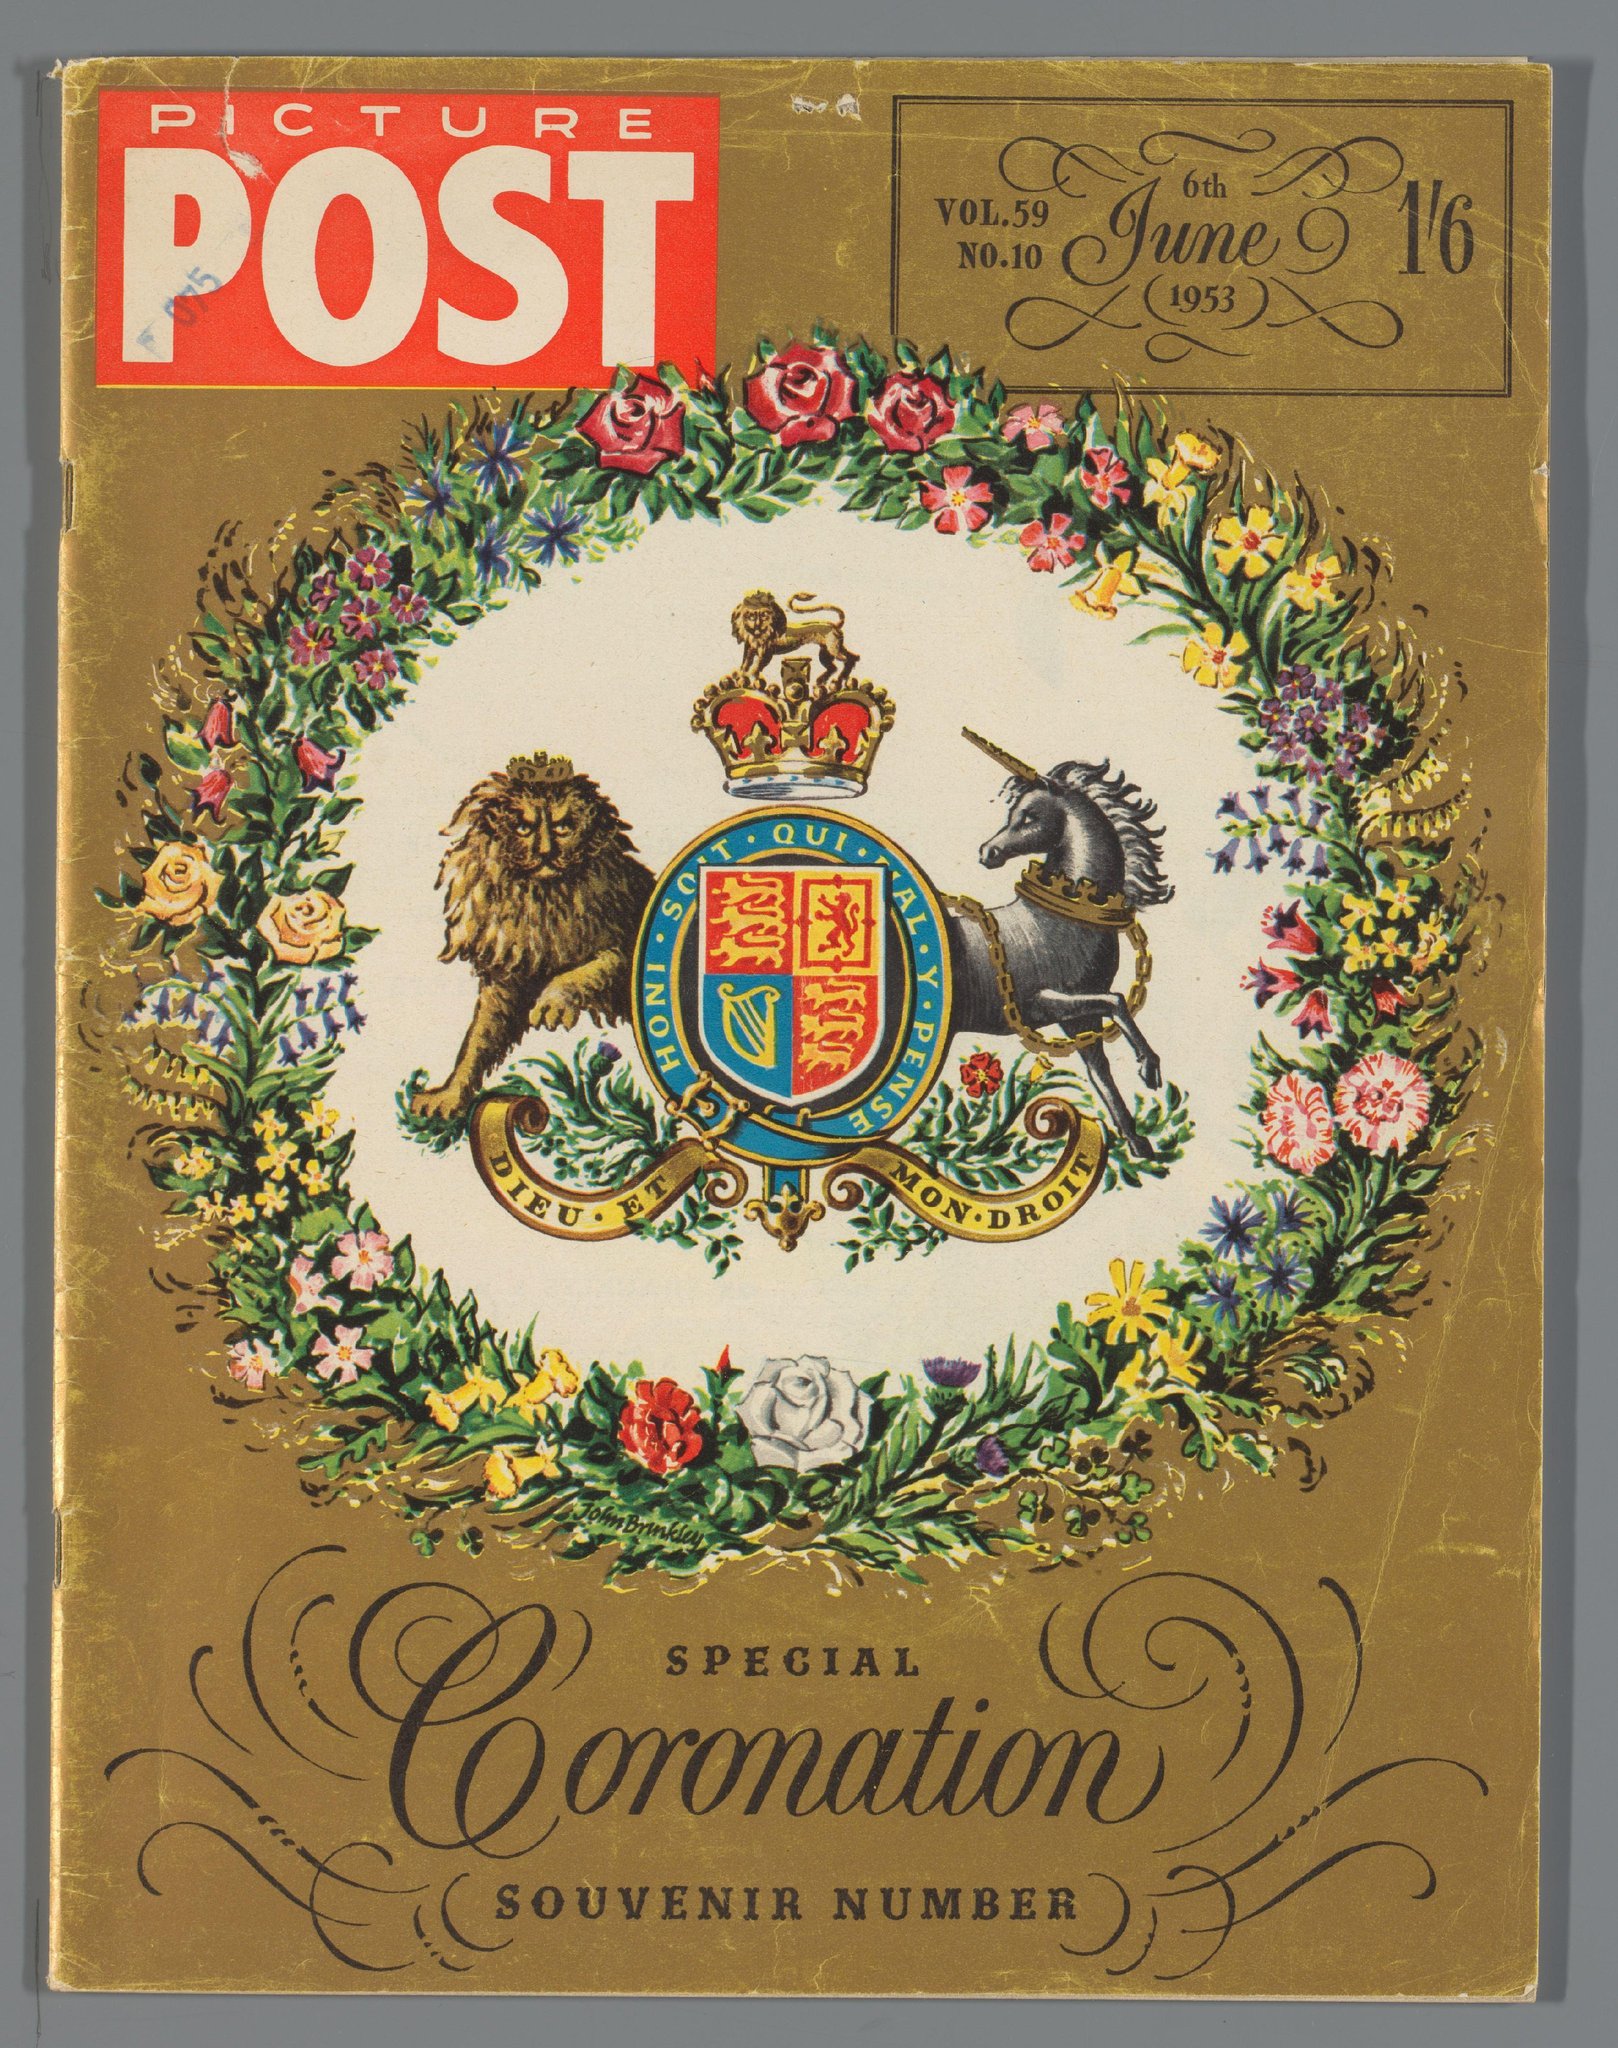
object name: print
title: Exemplaar van de speciale editie van de Picture Post tgv de kroning van koningin Elizabeth II, 6 juni 1953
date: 1953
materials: paper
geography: london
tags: coronation of a ruler - bb - female ruler, london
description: Exemplaar van de speciale editie van het tijdschrift 'Picture Post' van 6 juni 1953, ter gelegenheid van de kroning van koningin Elizabeth II op 2 juni 1953.